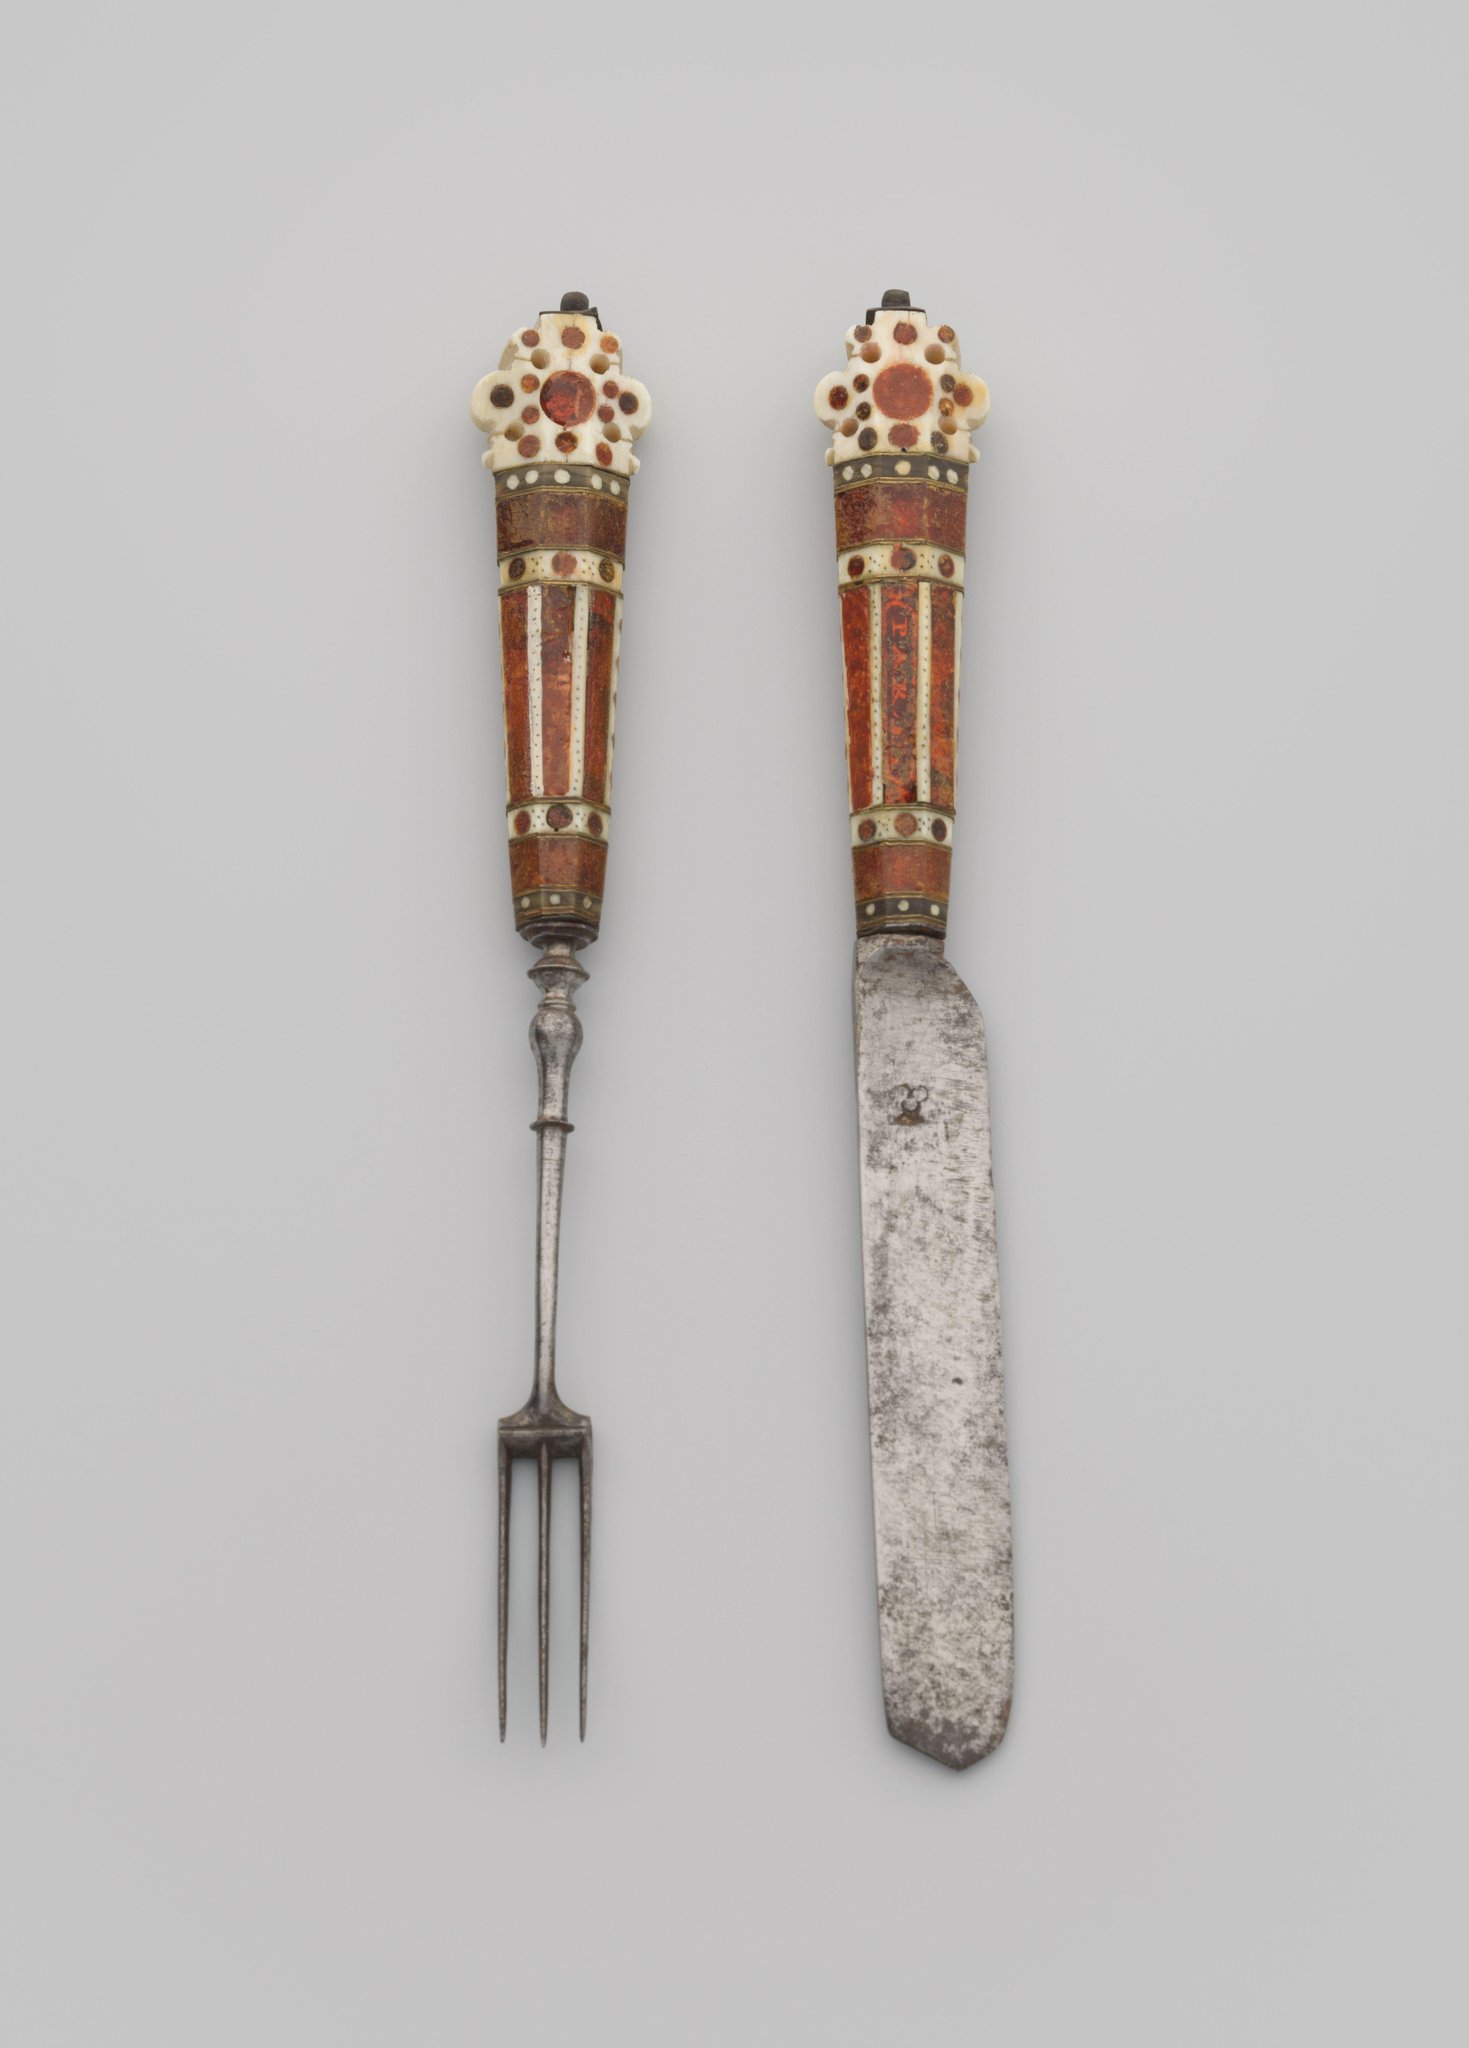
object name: knife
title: Mes met een barnsteen ivoren heft in foedraal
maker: Anonymous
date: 1600-1625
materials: ivory, silver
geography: königsberg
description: Een mes met een barnsteen ivoren heft en zilver knopjes.